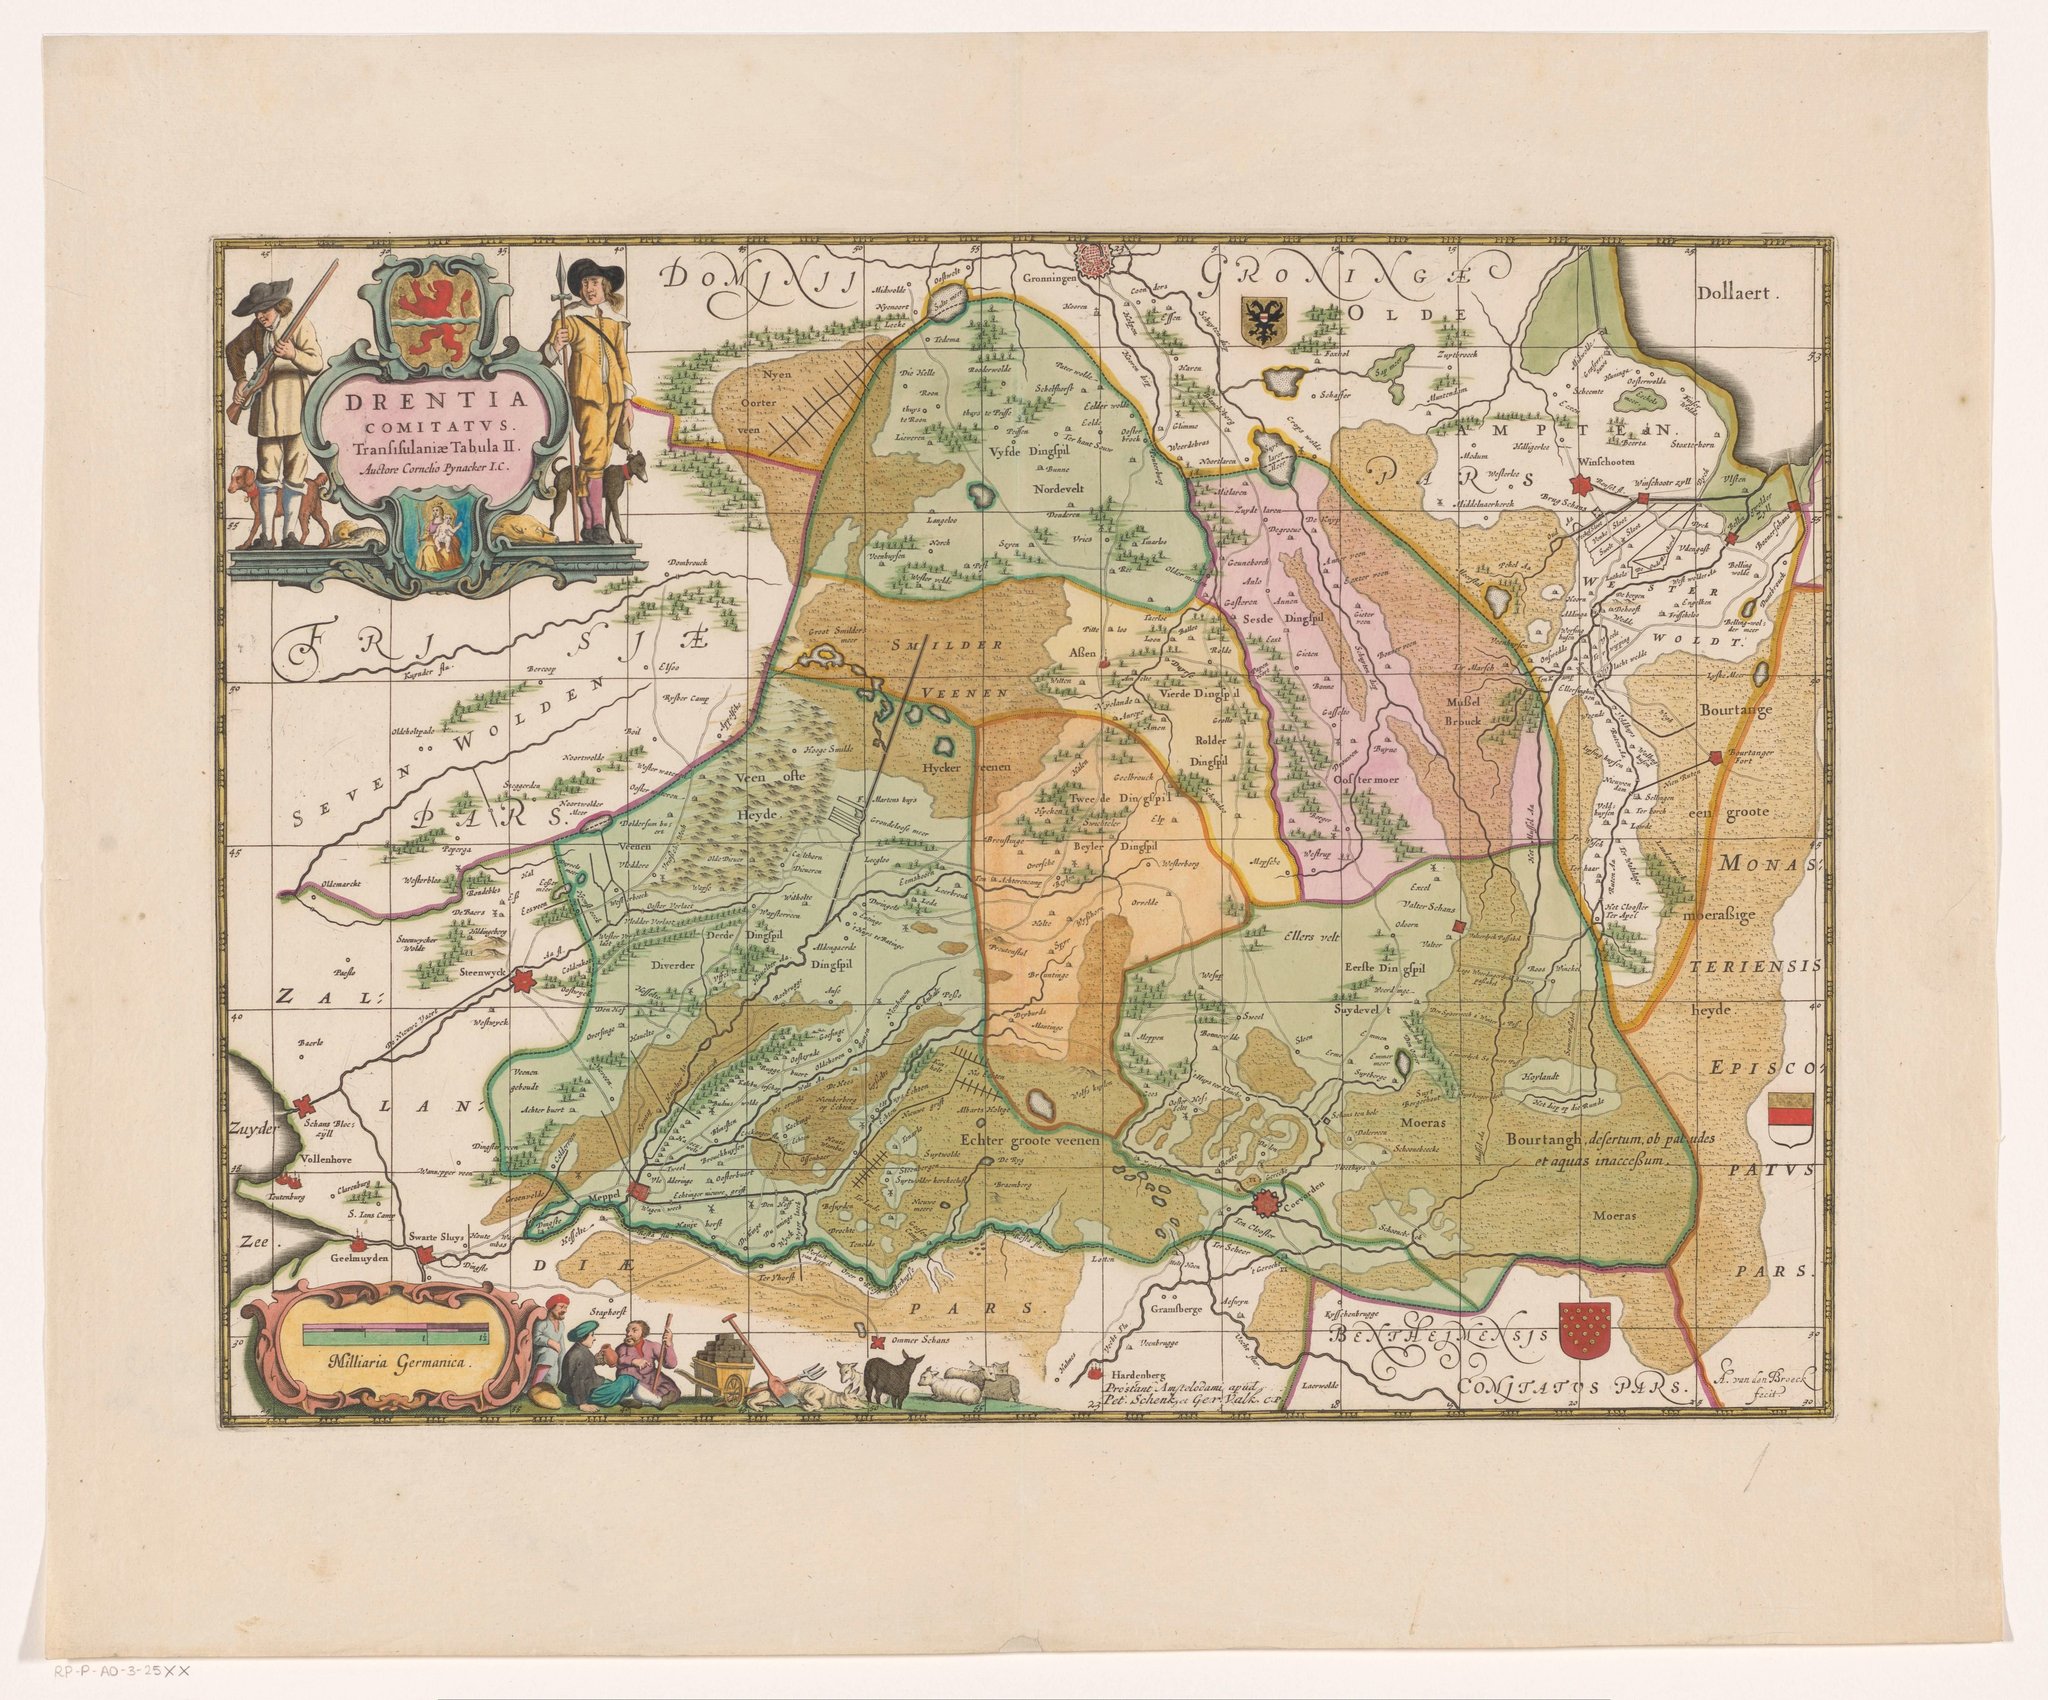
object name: print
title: Kaart van Drenthe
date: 1638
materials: paper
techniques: engraving, hand coloring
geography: amsterdam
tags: peat (soil type), coat of arms (as symbol of the state, etc.), maps of separate countries or regions, hunter, agriculture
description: Linksboven titelcartouche met het wapen van de Republiek en dat van Drenthe, daaromheen twee jagers. Linksonder een schaalstok: Milliaria Germanica. Daarnaast drie mannen, turf en vee. De kaart is voorzien van een zoekrooster.